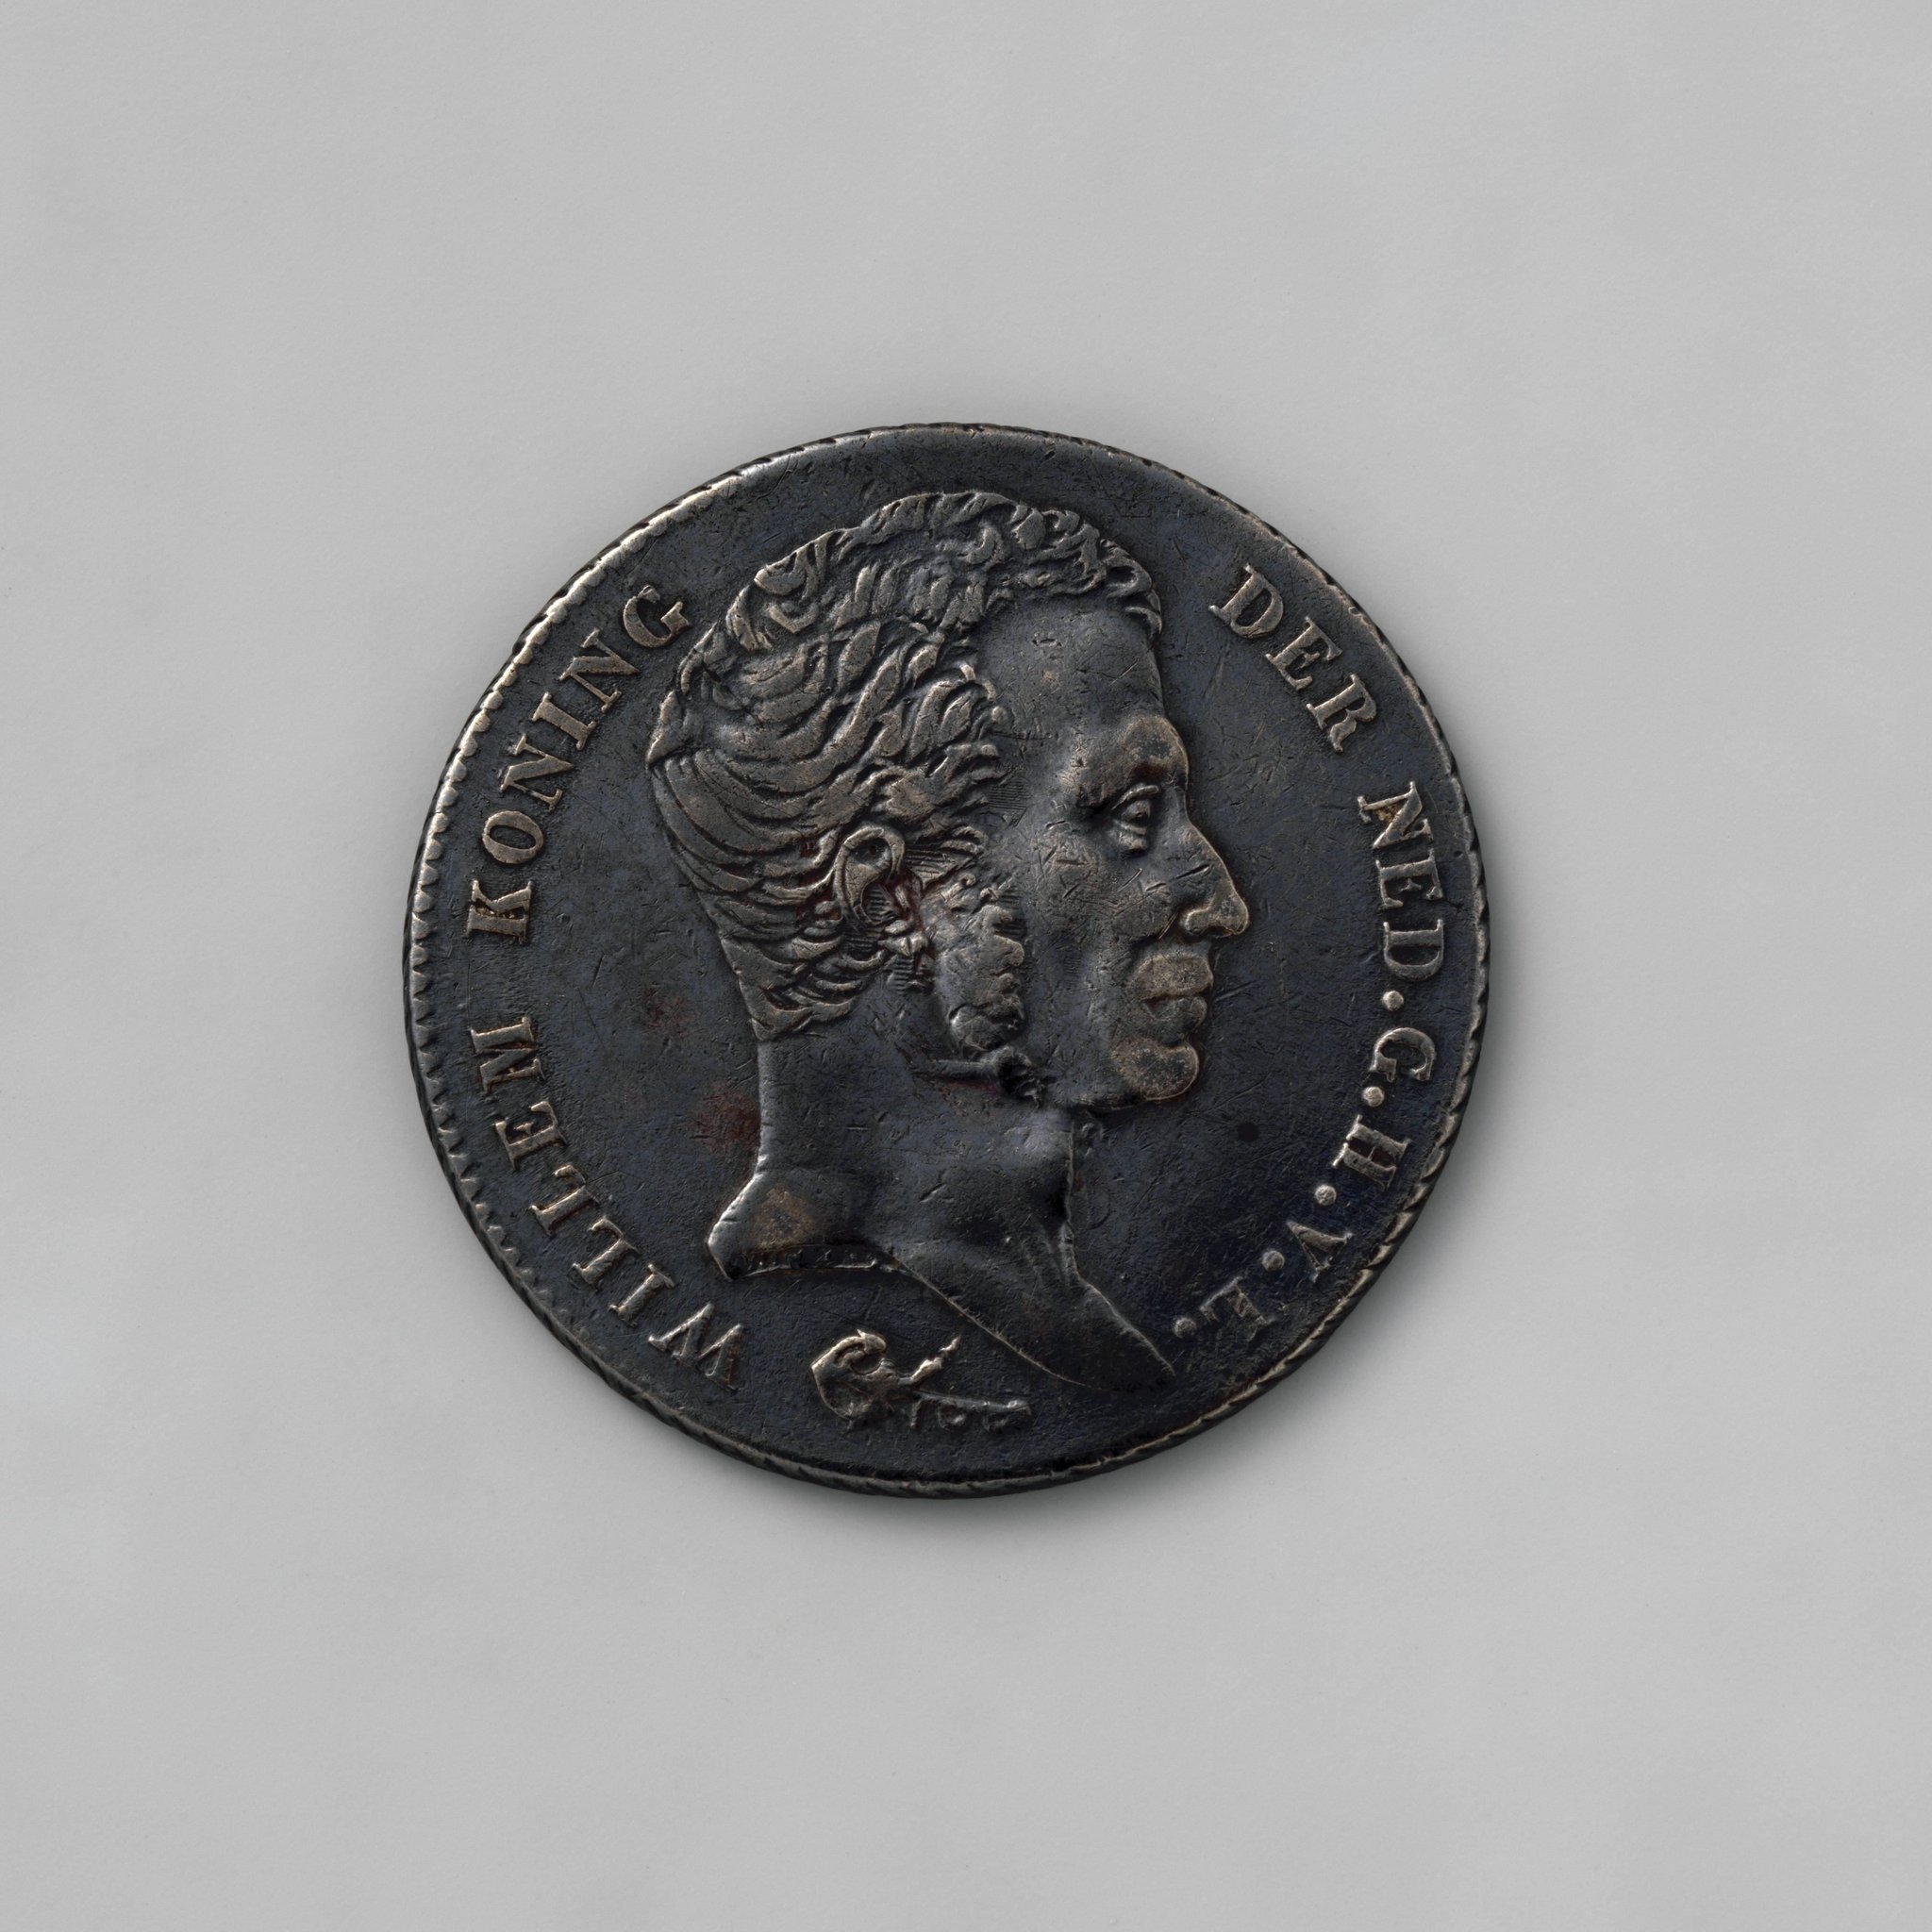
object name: coin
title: Nederlands Indië, gulden, 1821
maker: william i of the netherlands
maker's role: koning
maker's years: 1772-1843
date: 1821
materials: silver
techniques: striking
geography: utrecht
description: Zilveren munt. Voorzijde: borstbeeld naar rechts. Keerzijde: tussen waarde-aanduiding 1 G gekroond rijkswapenschild. Jaartal boven kroon. Kabelrand